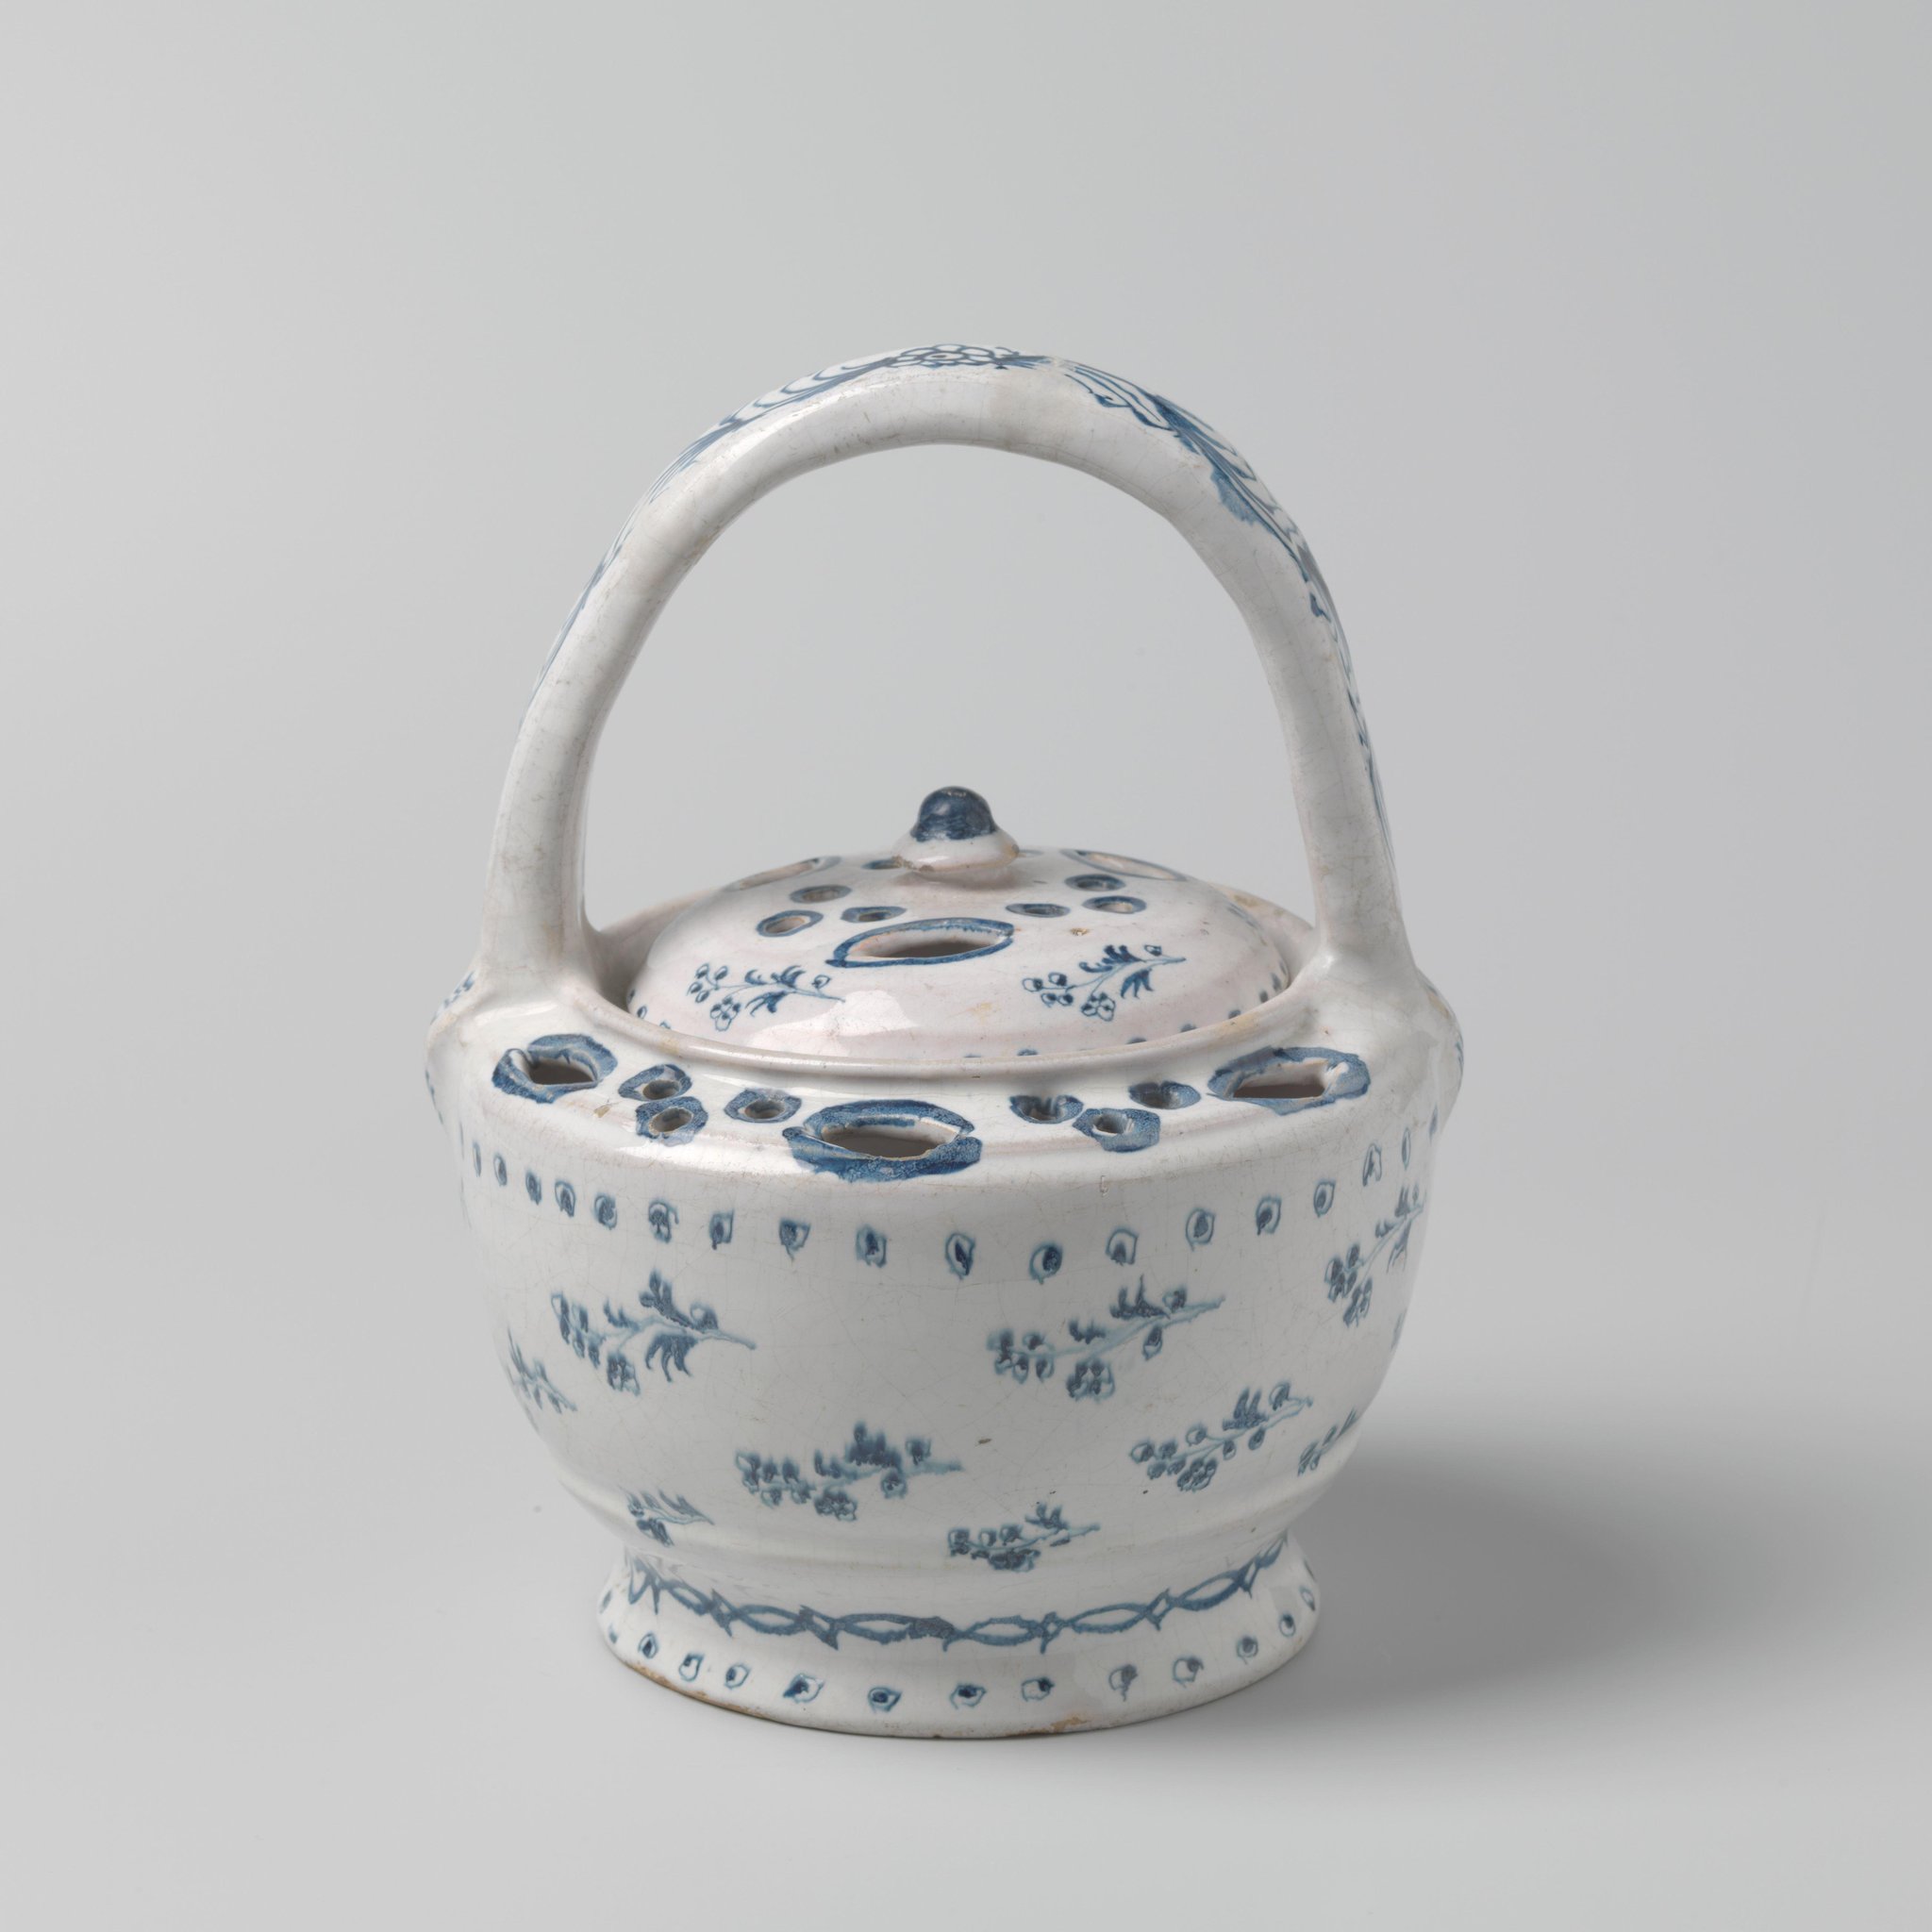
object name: tureen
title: Terrine, beschilderd met strooibloemen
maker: Anonymous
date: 1775-1820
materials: faience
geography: brussels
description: Terrine van faience. Blauw beschilderd met strooibloemen.